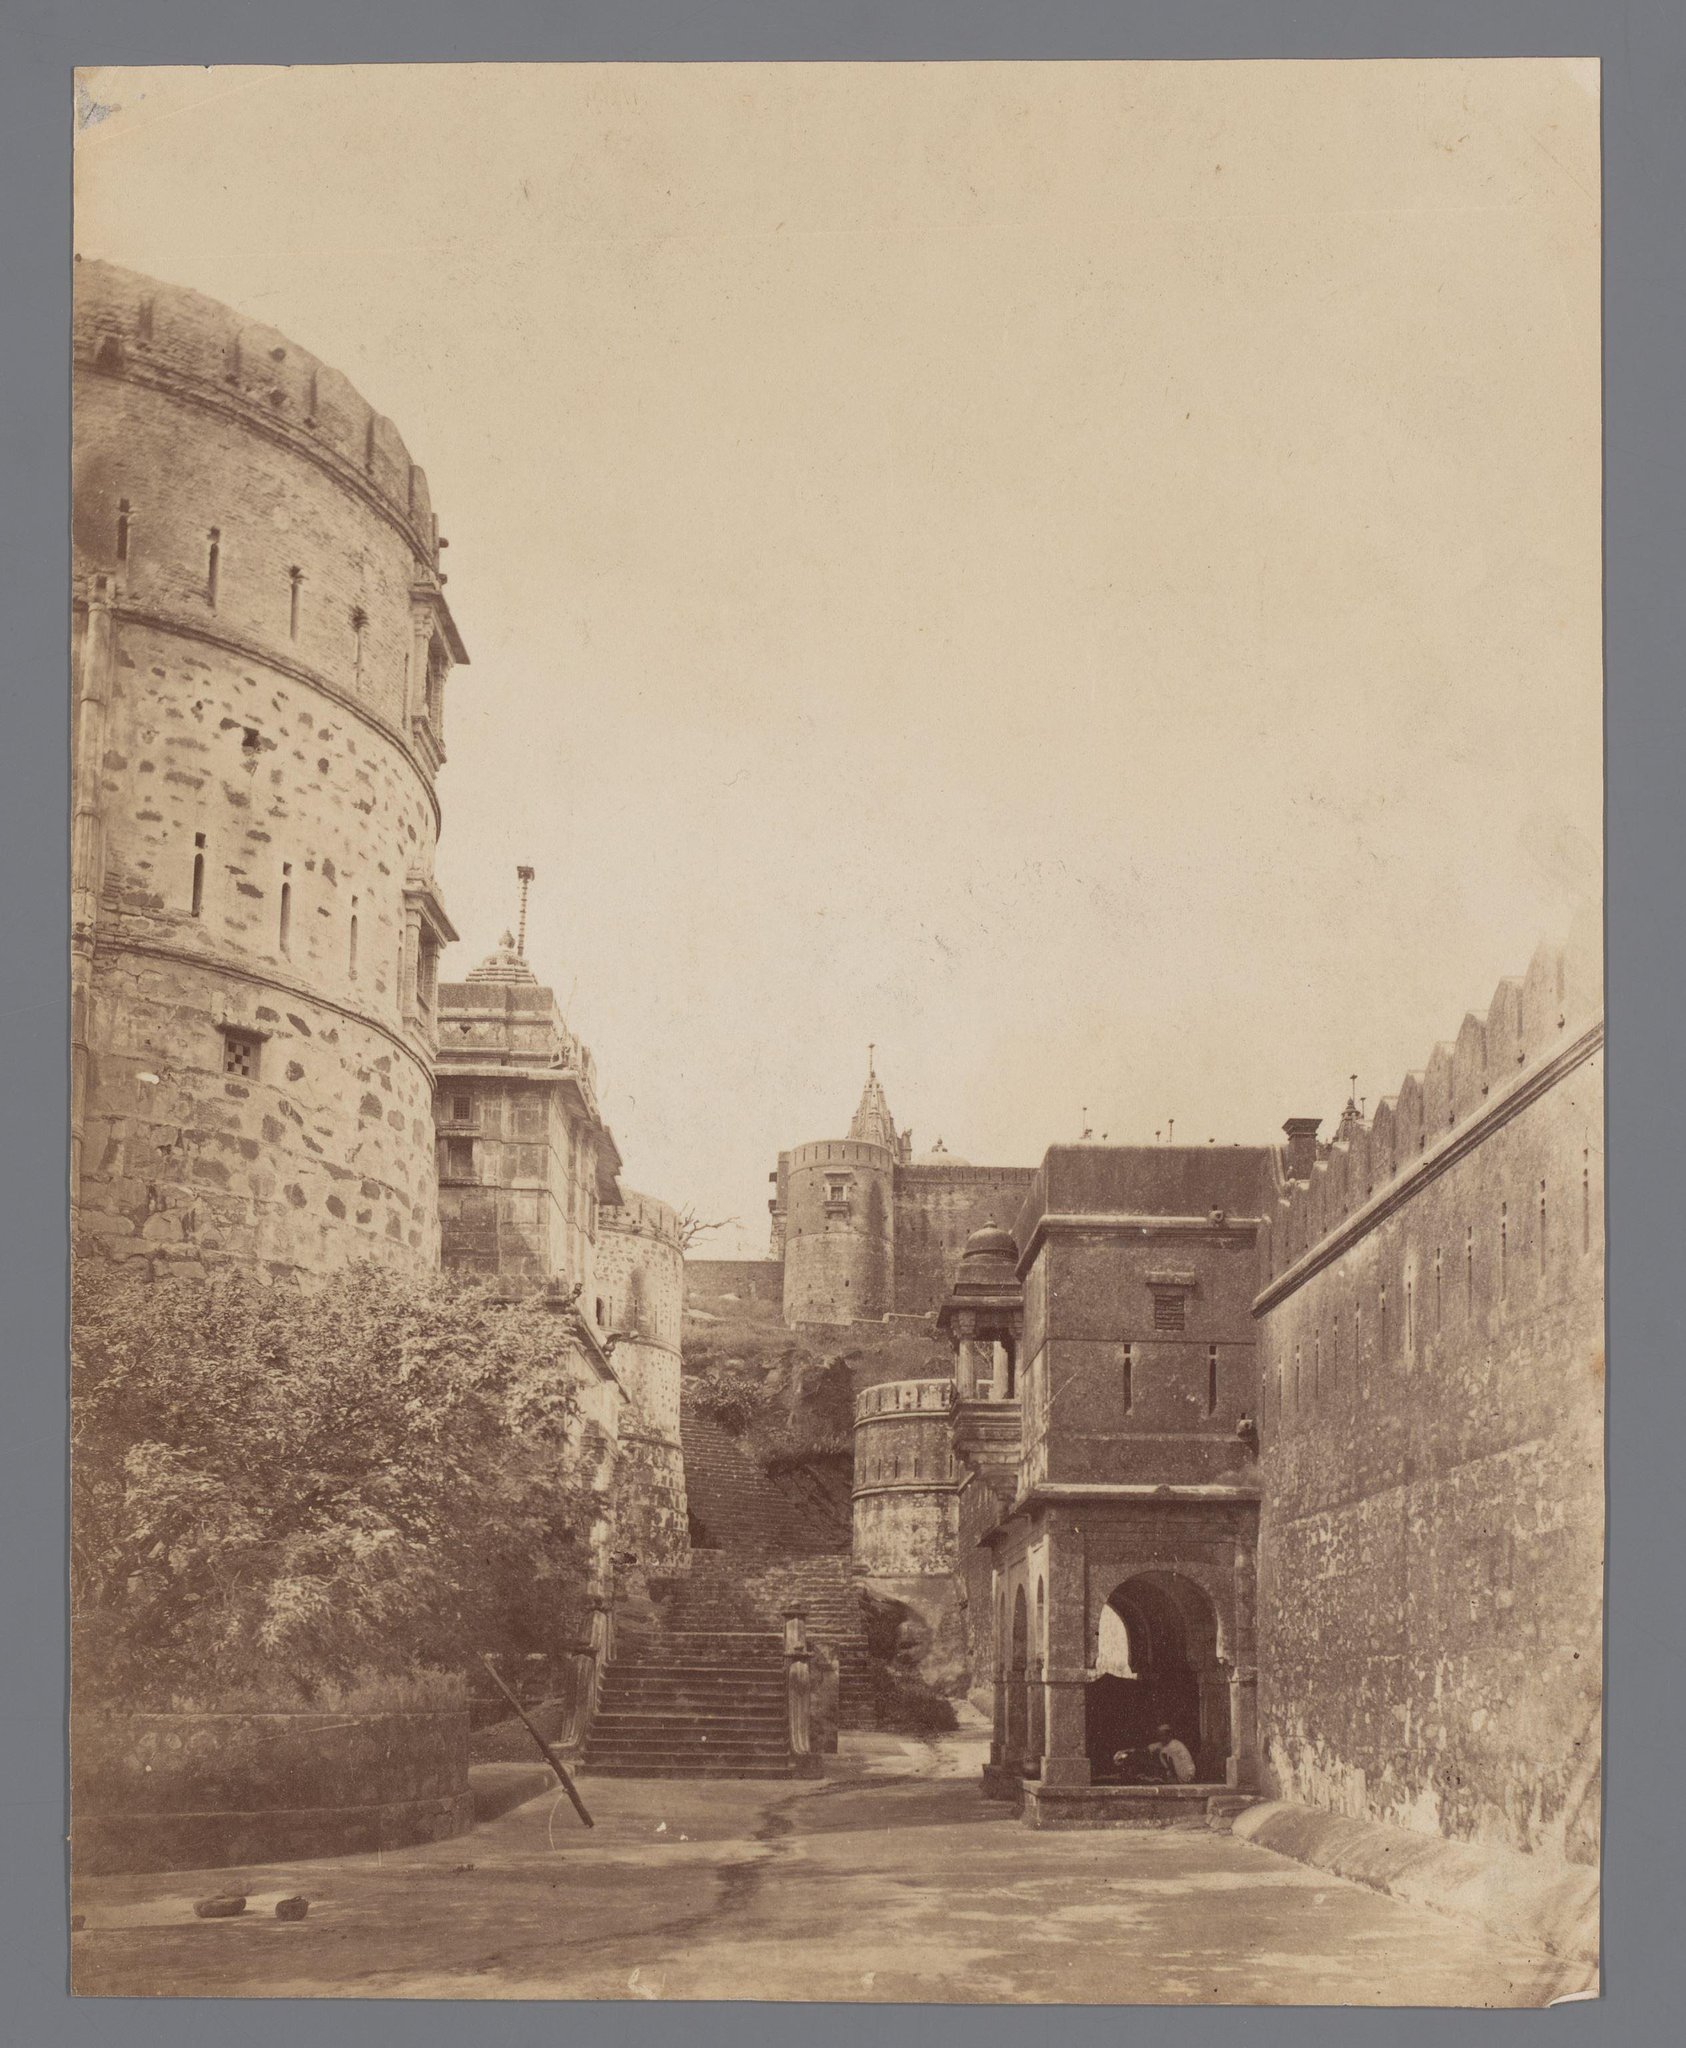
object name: photograph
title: Temple complex at Palitana, Gujarat, India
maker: Anonymous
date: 1870-1900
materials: paper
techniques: albumen print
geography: palitana